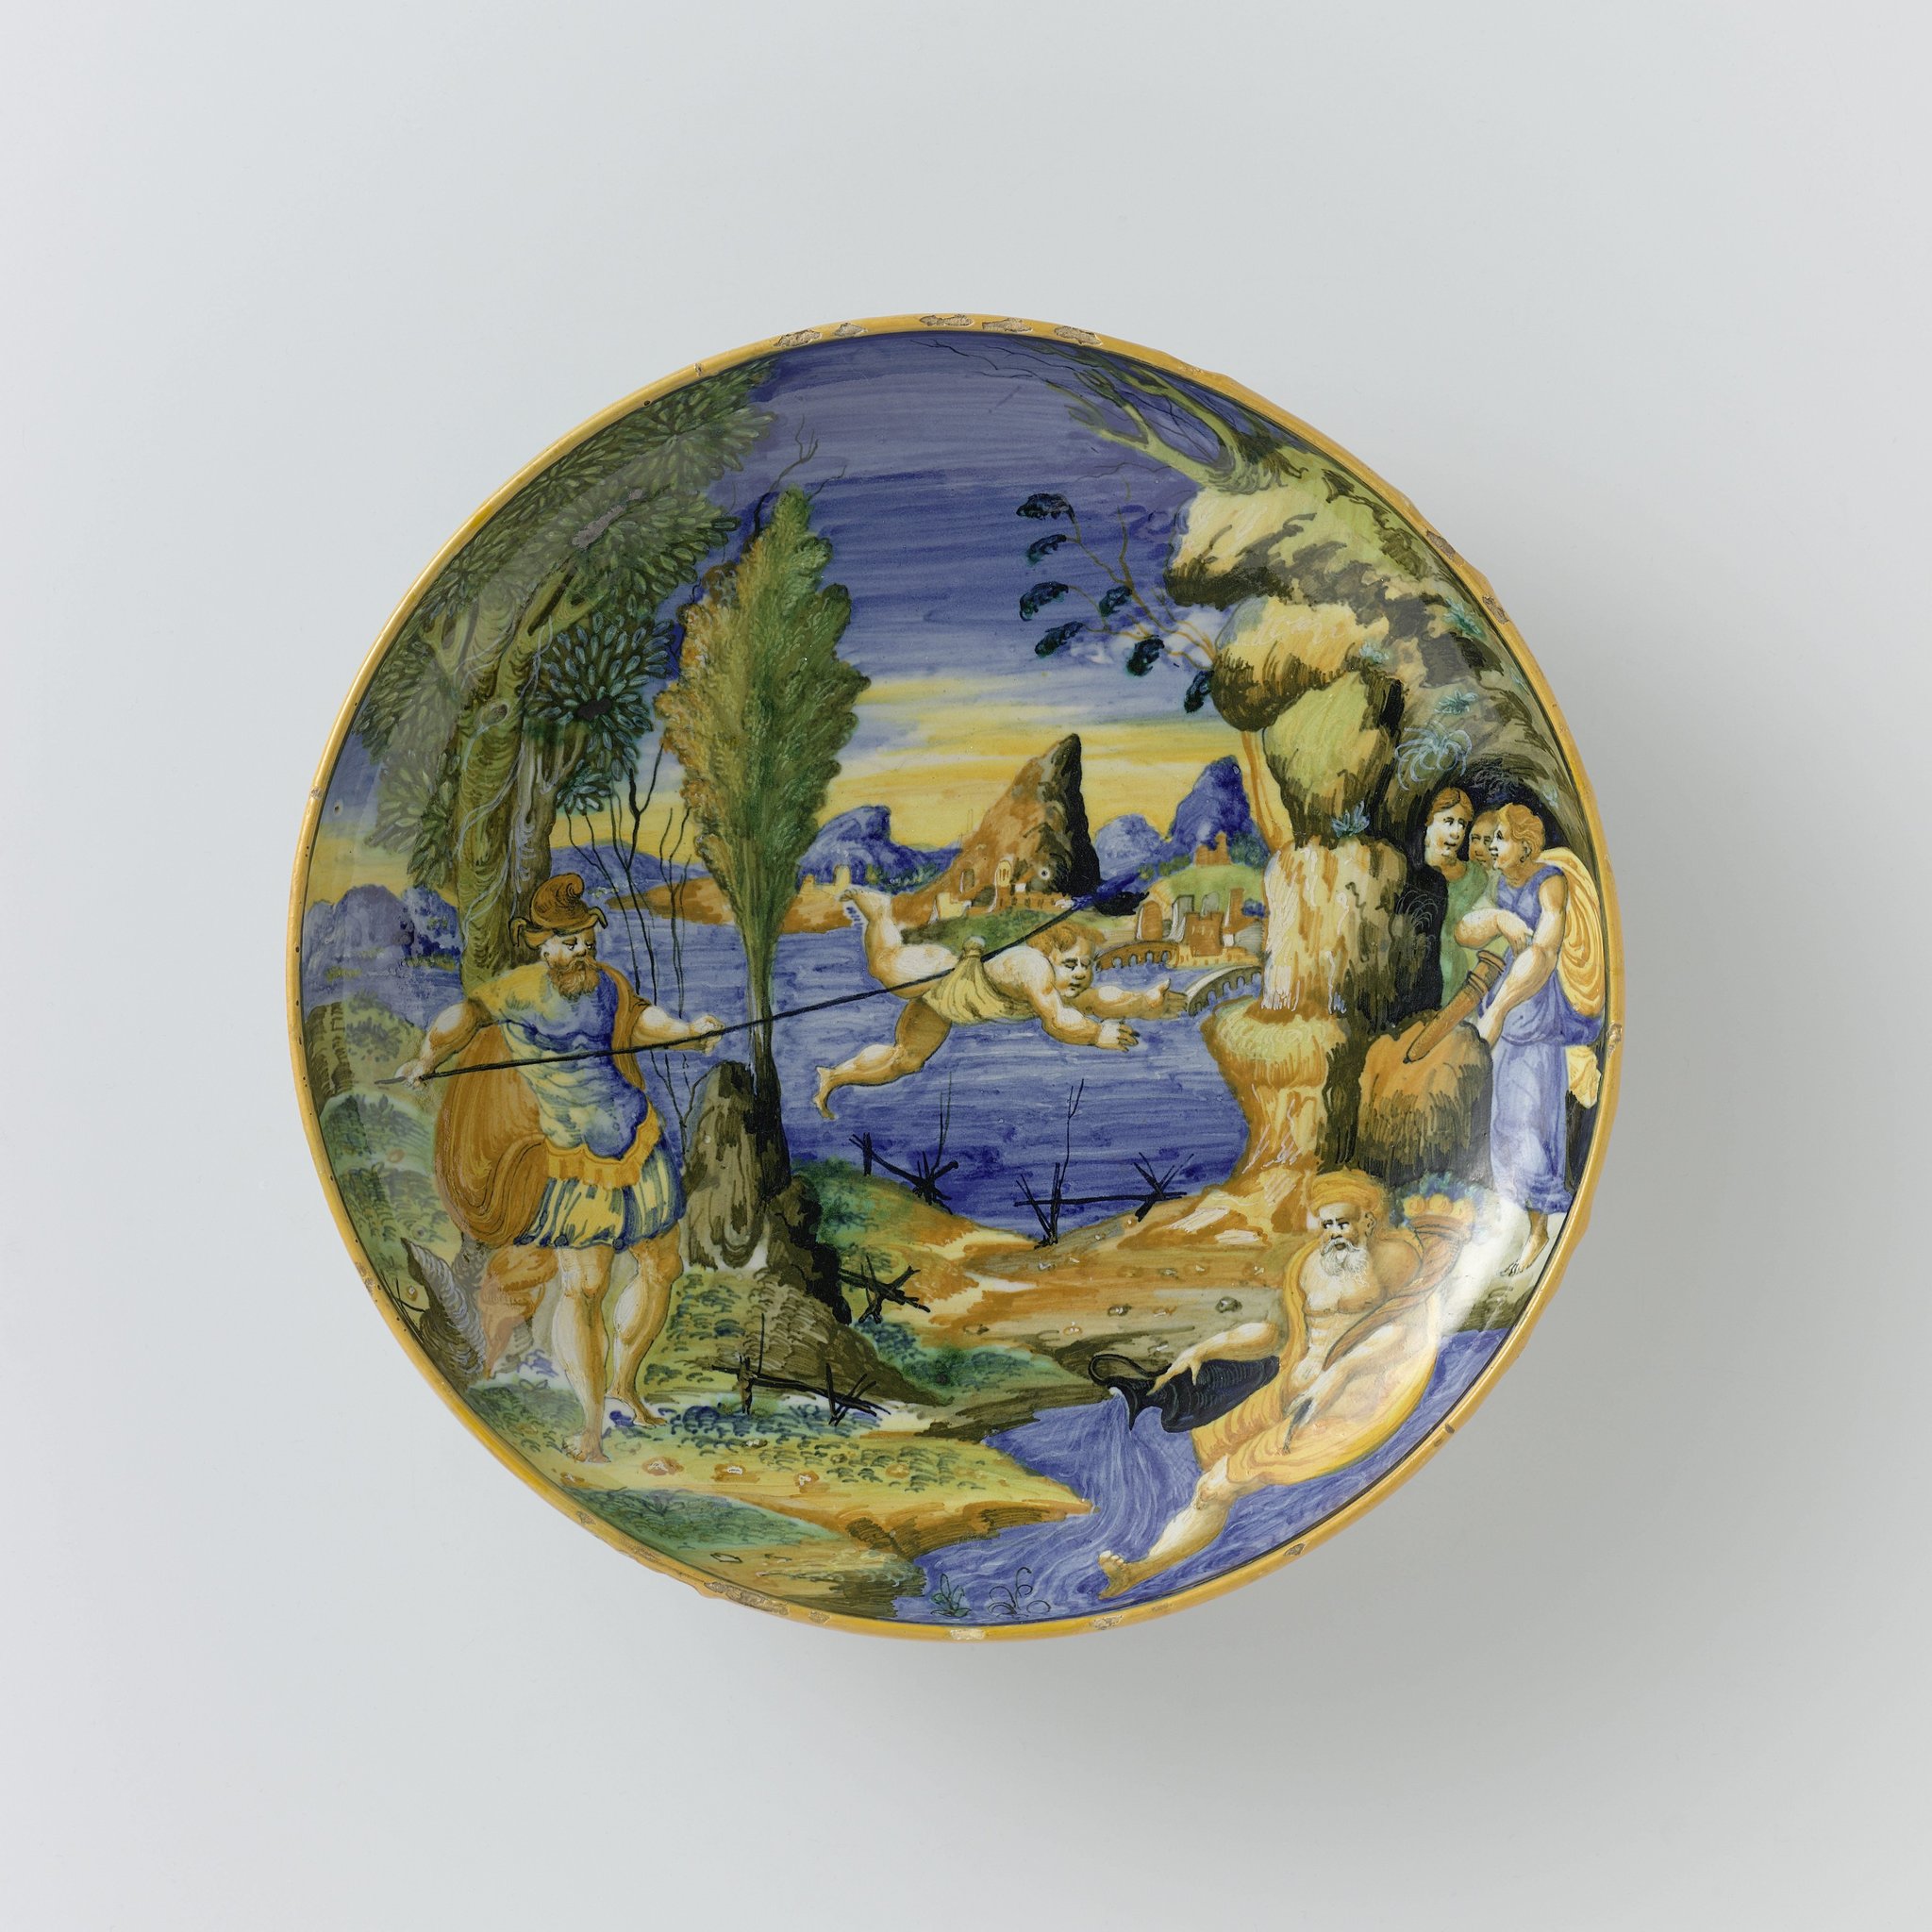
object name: platter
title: Dish with Metabus Throwing Camilla across the River Amasenus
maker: Anonymous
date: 1544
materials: earthenware, glaze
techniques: maiolica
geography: urbino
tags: metabus, camilla's father, with the enemy almost upon him, throws the baby camilla, lashed on his spear, over the river amasenus and invokes diana's help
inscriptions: inscription: ‘Methapo oltr Amasce // lancio Camilla // 1544’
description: Ronde schotel op voet van veelkleurig beschilderde majolica. Afgebeeld is Metabus die Camilla over de rivier de Amasenus werpt, ontleend aan de Aeneas van Vergilius. Op de linkeroever van de Amasenus staat Metabus een speer in zijn handen, waaraan Camilla met een doek is vastgebonden. Hiermee reikt hij naar de andere oever, waarop drie vrouwen staan. In het water ligt een riviergod. Op de achterkant van het bord het opschrift: Methapo oltr Amasce // lancio Camilla // 1544.